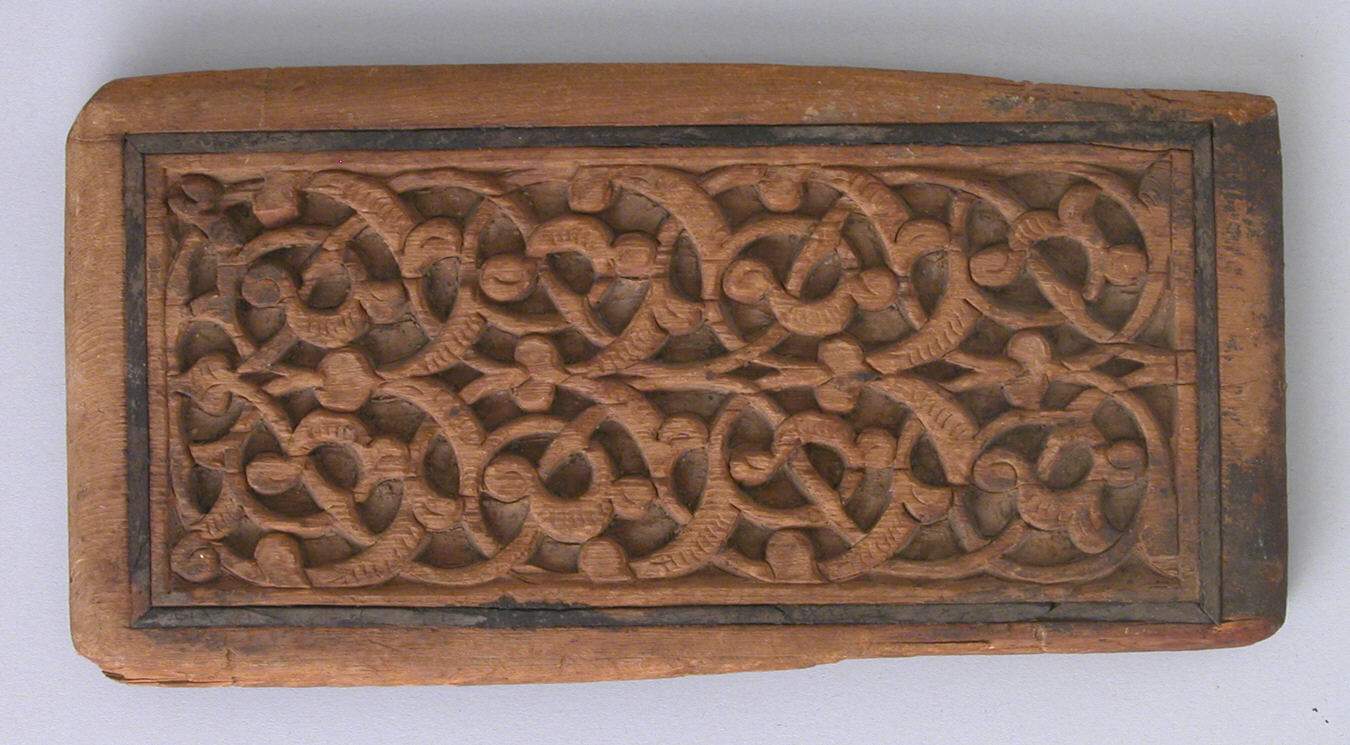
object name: panel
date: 1301-1500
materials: wood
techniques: carving, inlay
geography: egypt